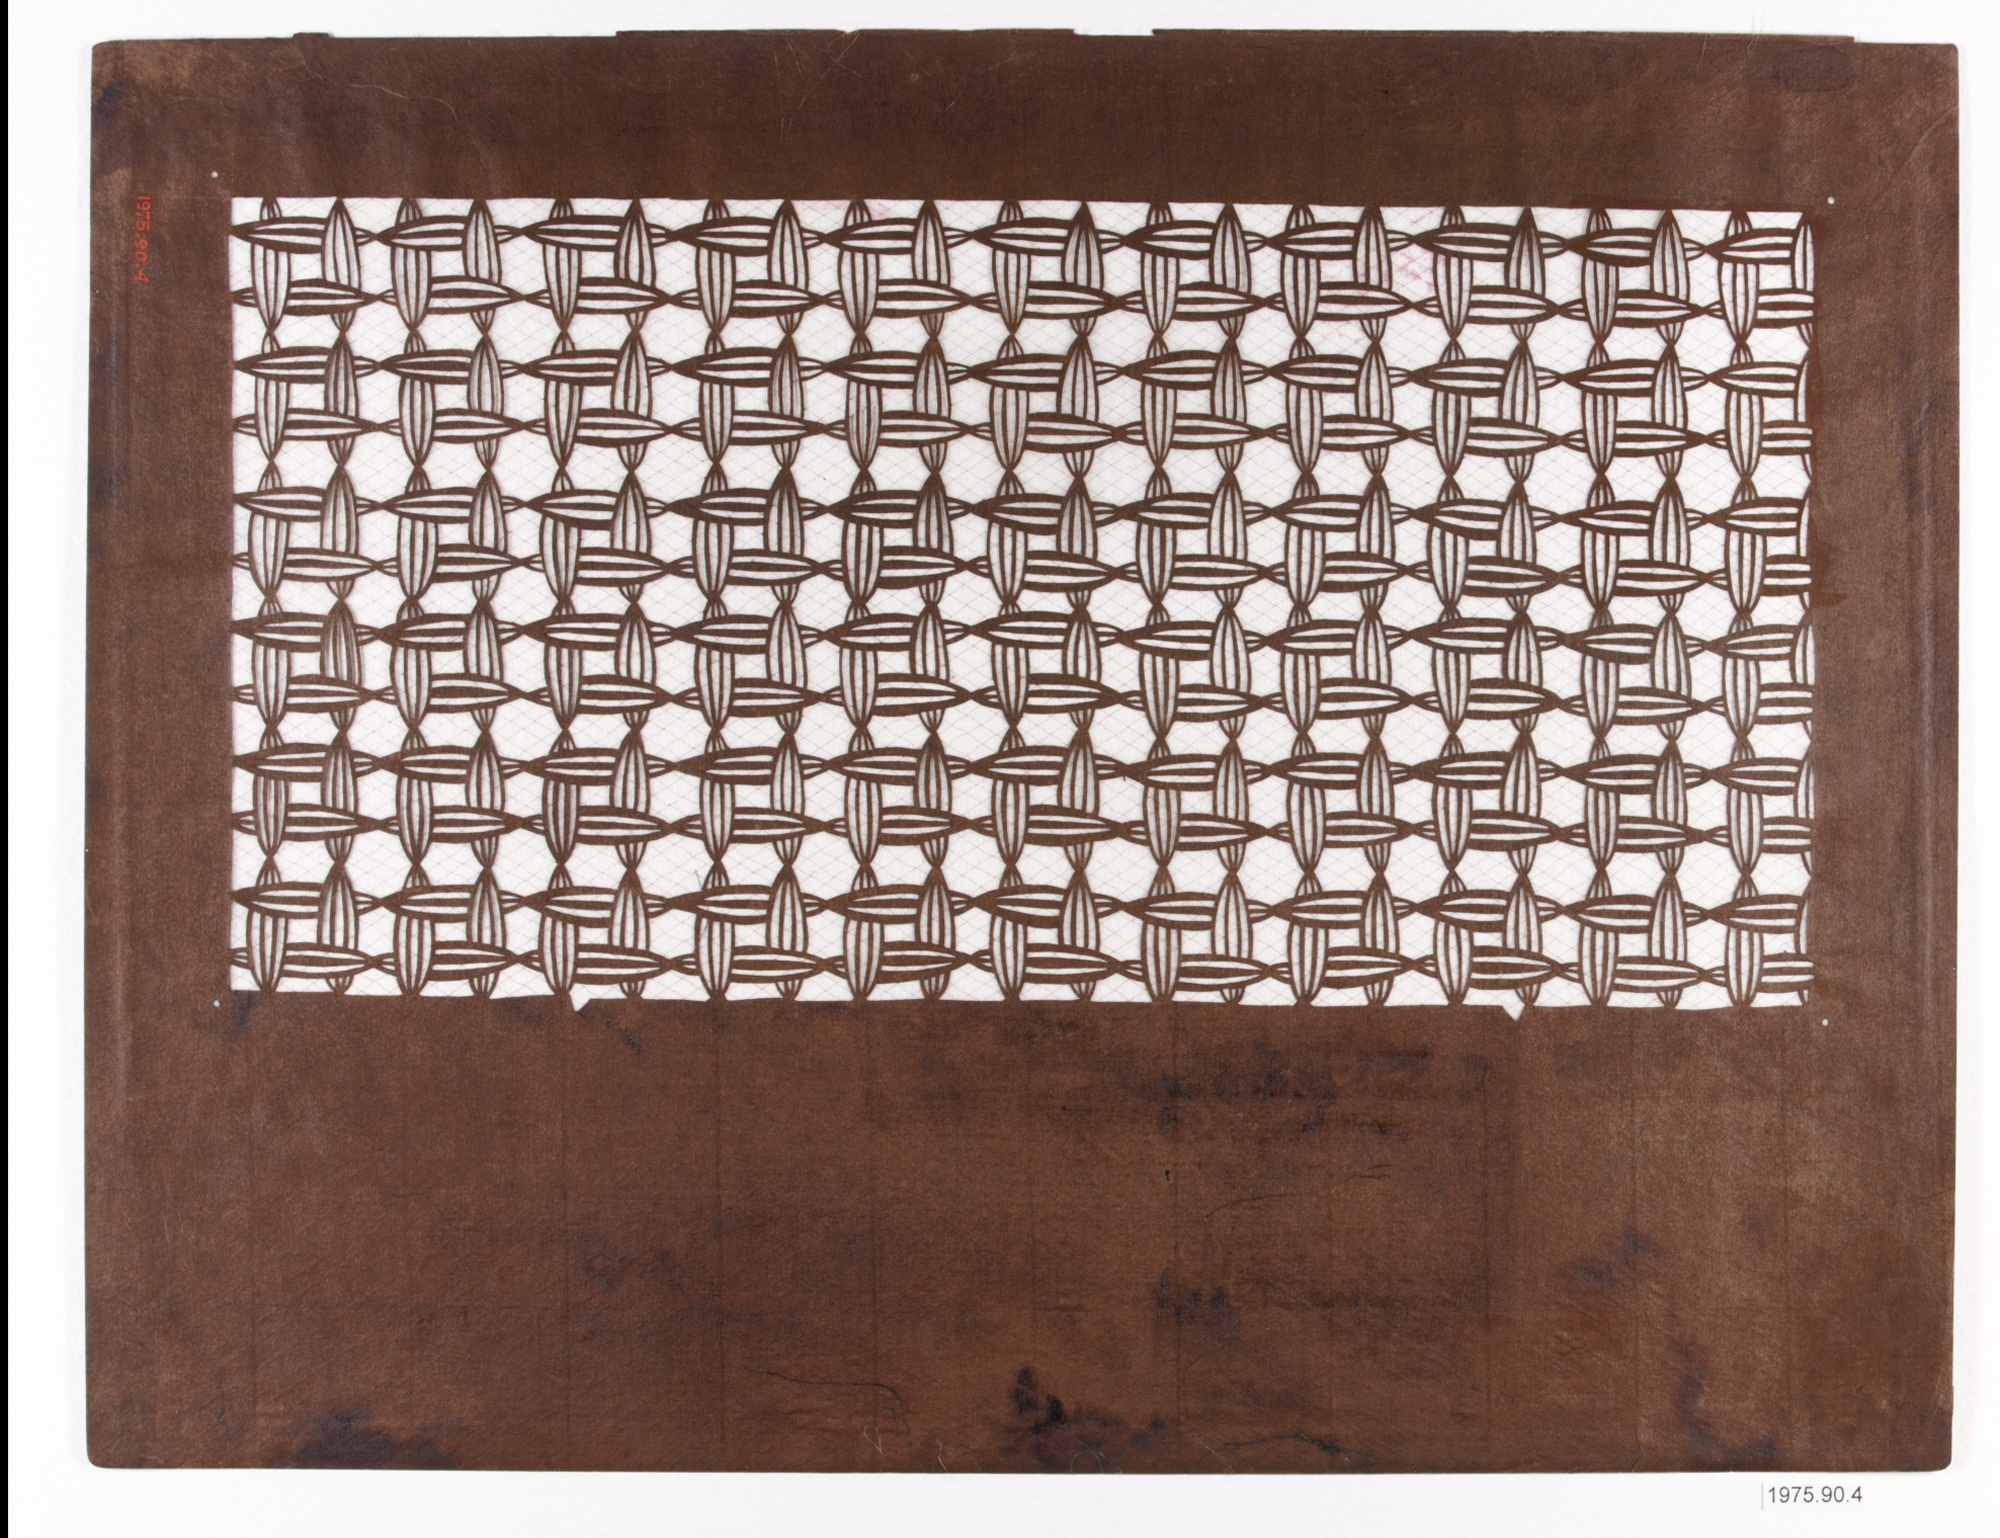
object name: stencil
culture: japanese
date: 1867-1933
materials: paper, silk